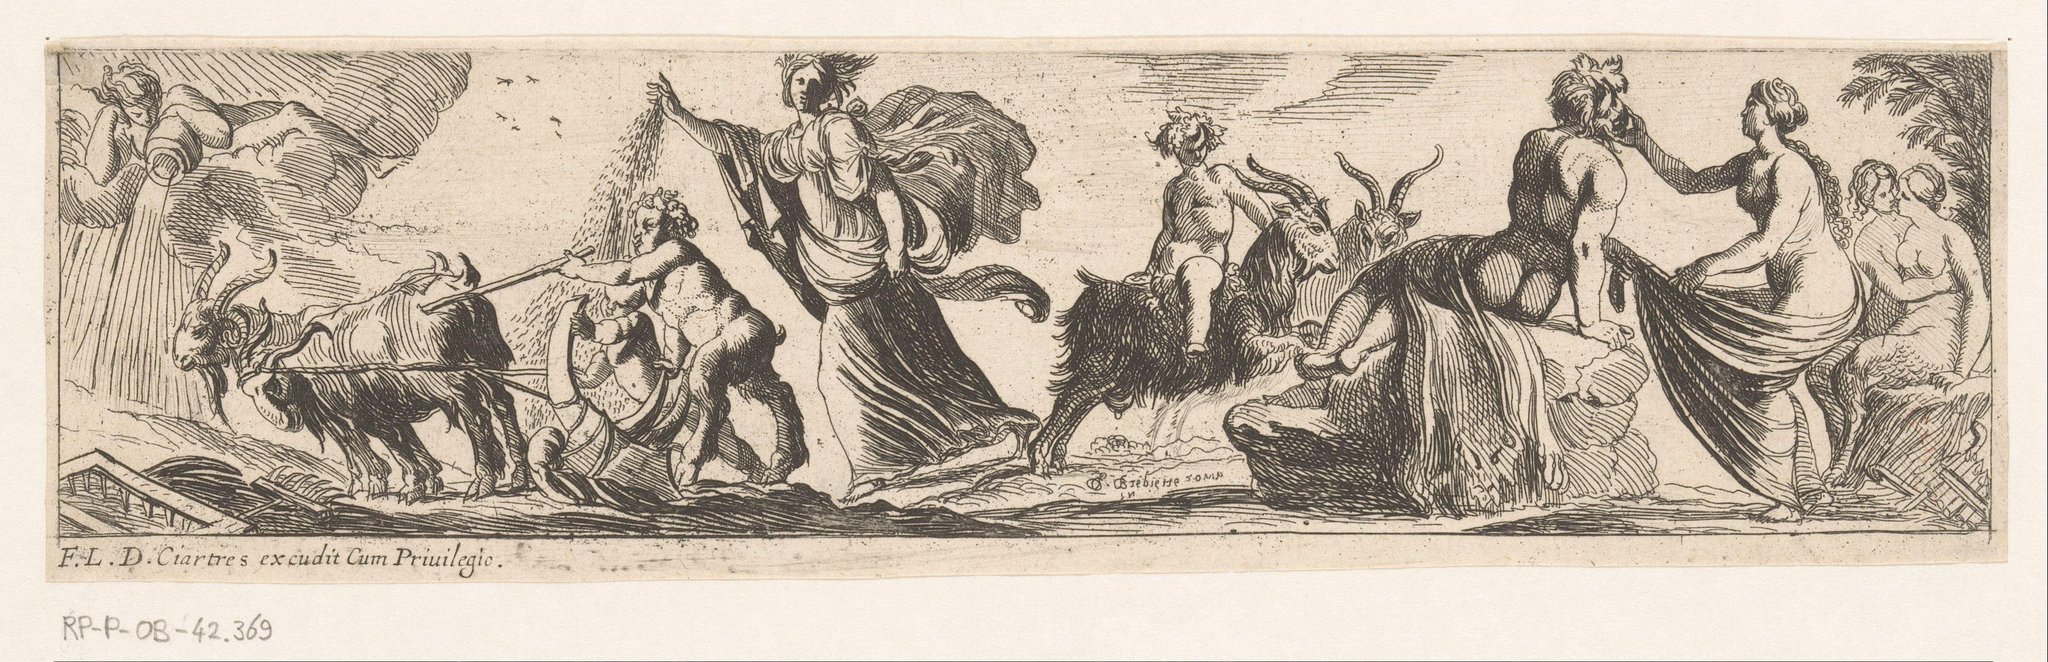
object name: print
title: Zaaiende Ceres op een akker met nimfen en saters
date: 1617-1626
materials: paper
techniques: etching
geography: rome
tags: (story of) ceres (demeter), nymphs (in general); 'ninfe in commune' (ripa), satyr(s) (in general), sowing, goat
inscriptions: collector's mark: Lugt 240